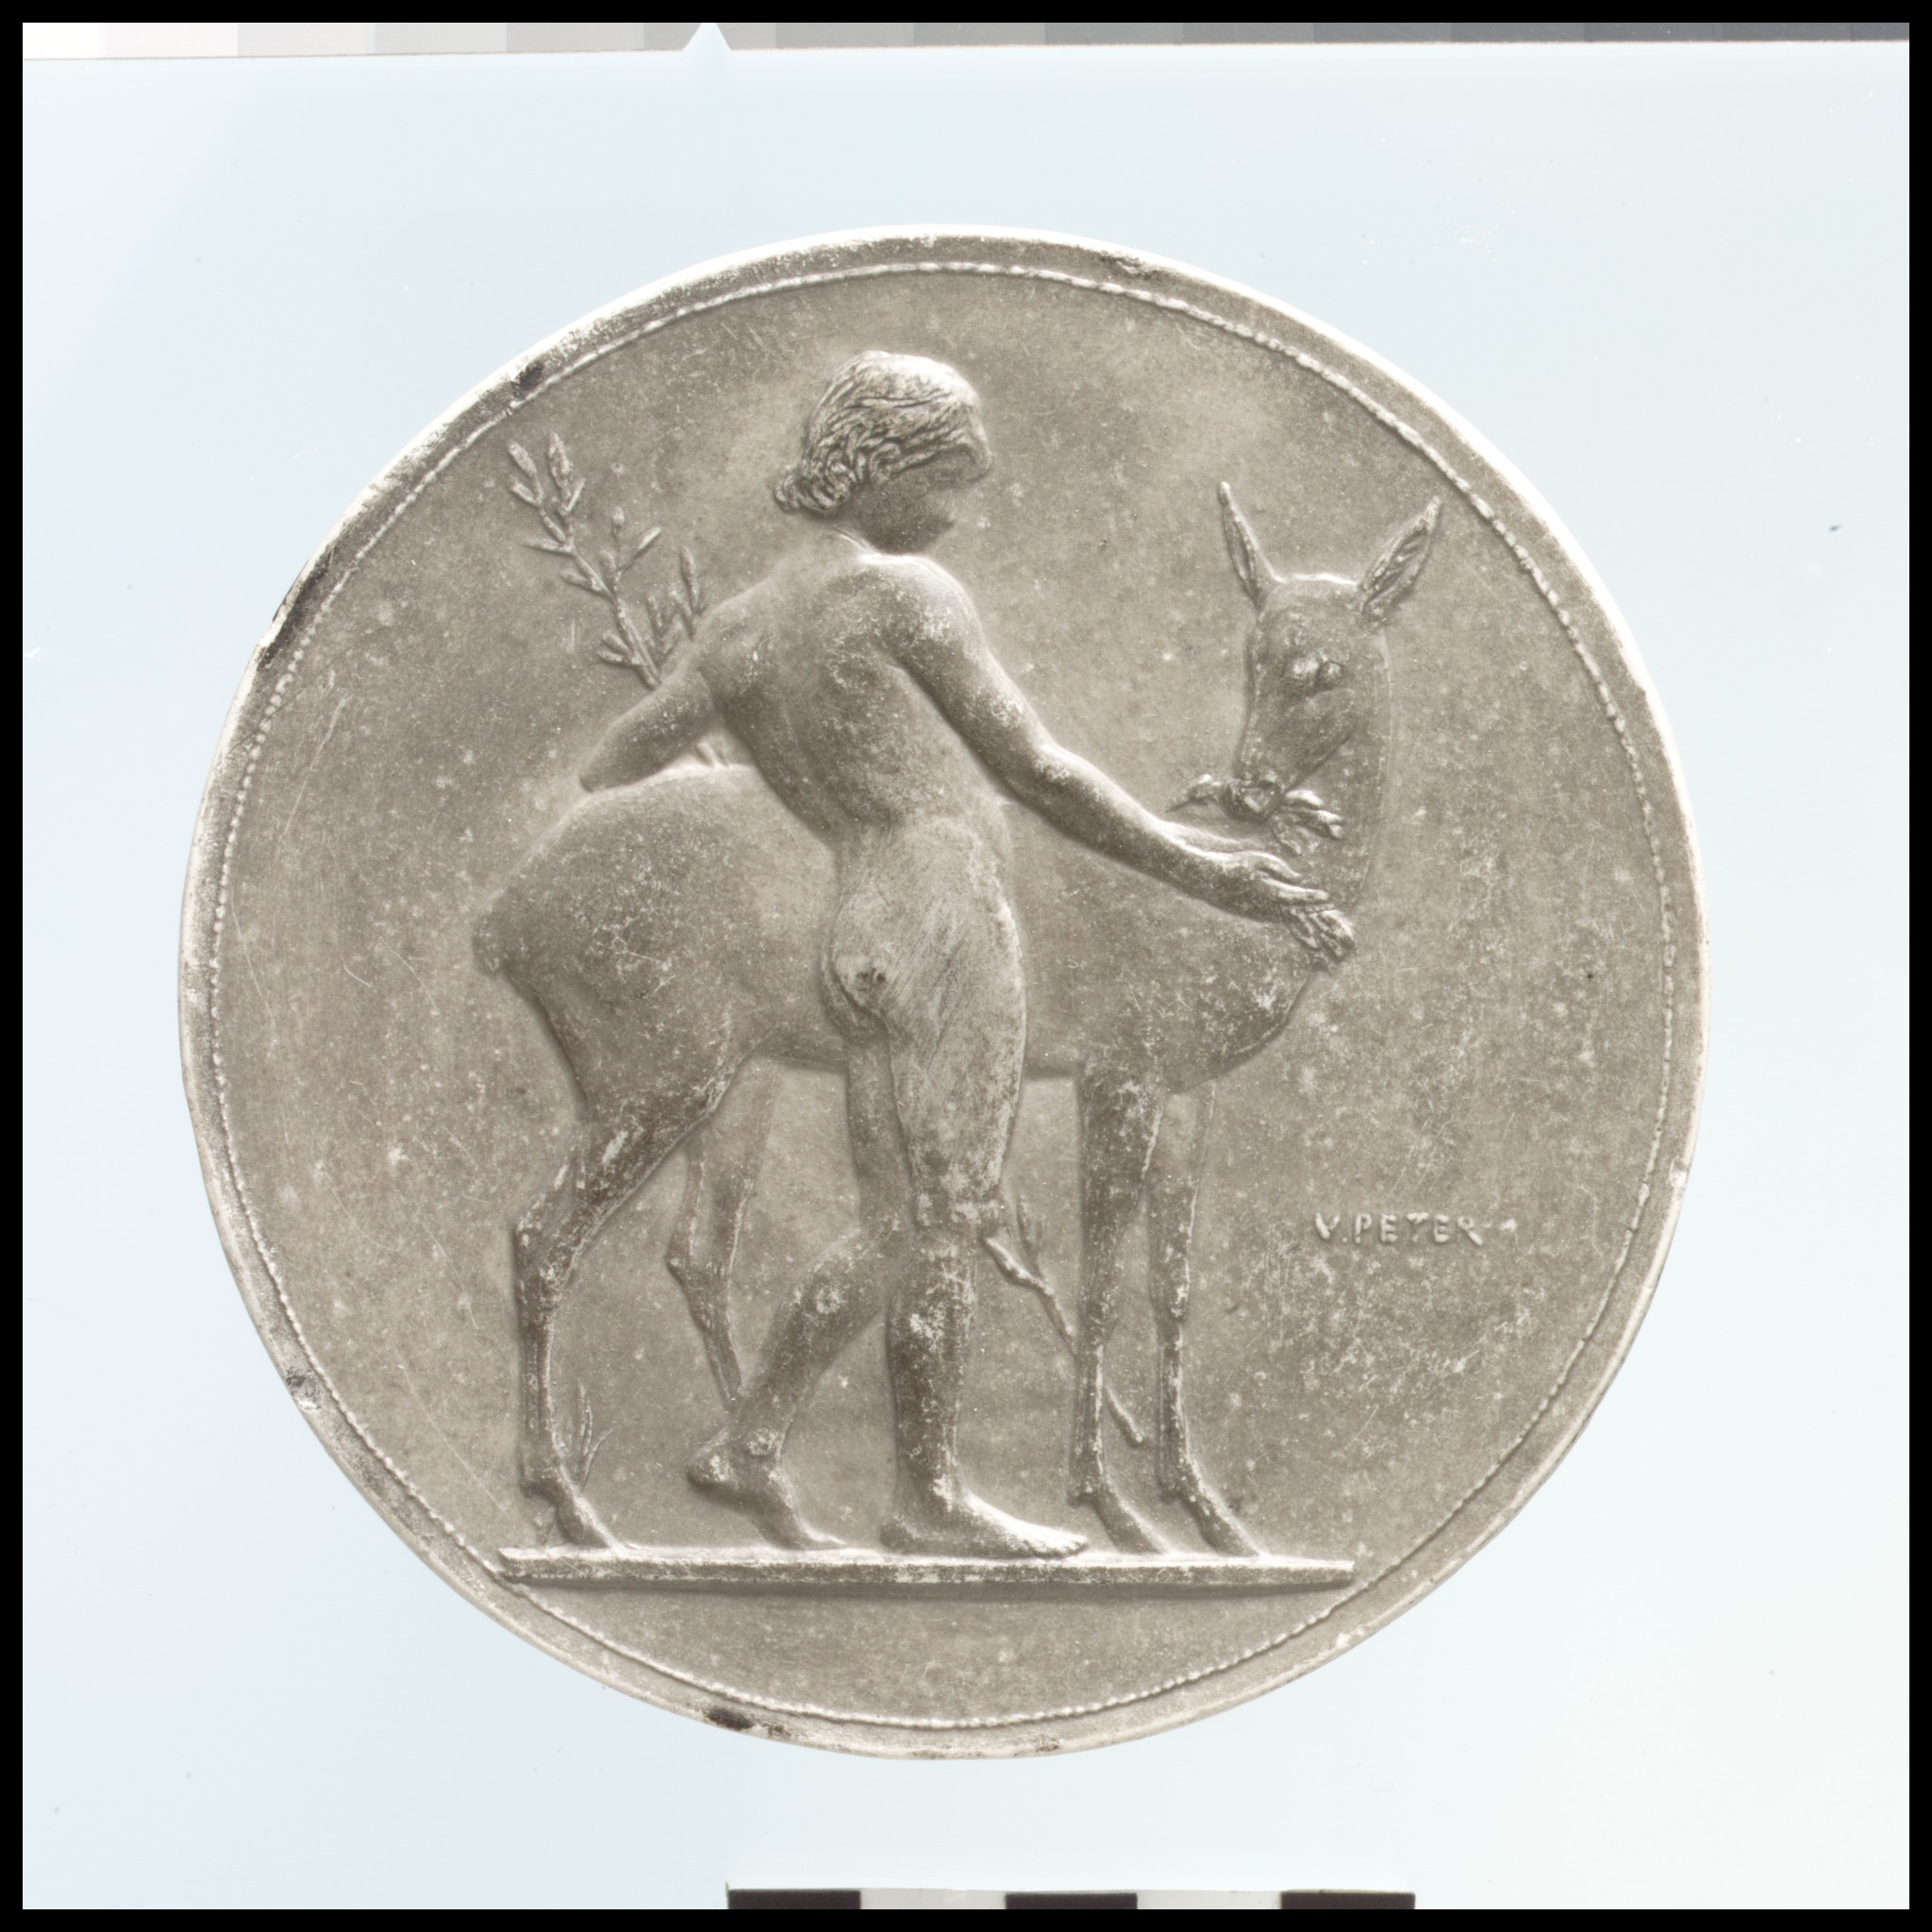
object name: medallion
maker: victor peter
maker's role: maker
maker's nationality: french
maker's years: 1840-1918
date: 1900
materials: plaster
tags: human figures,deer